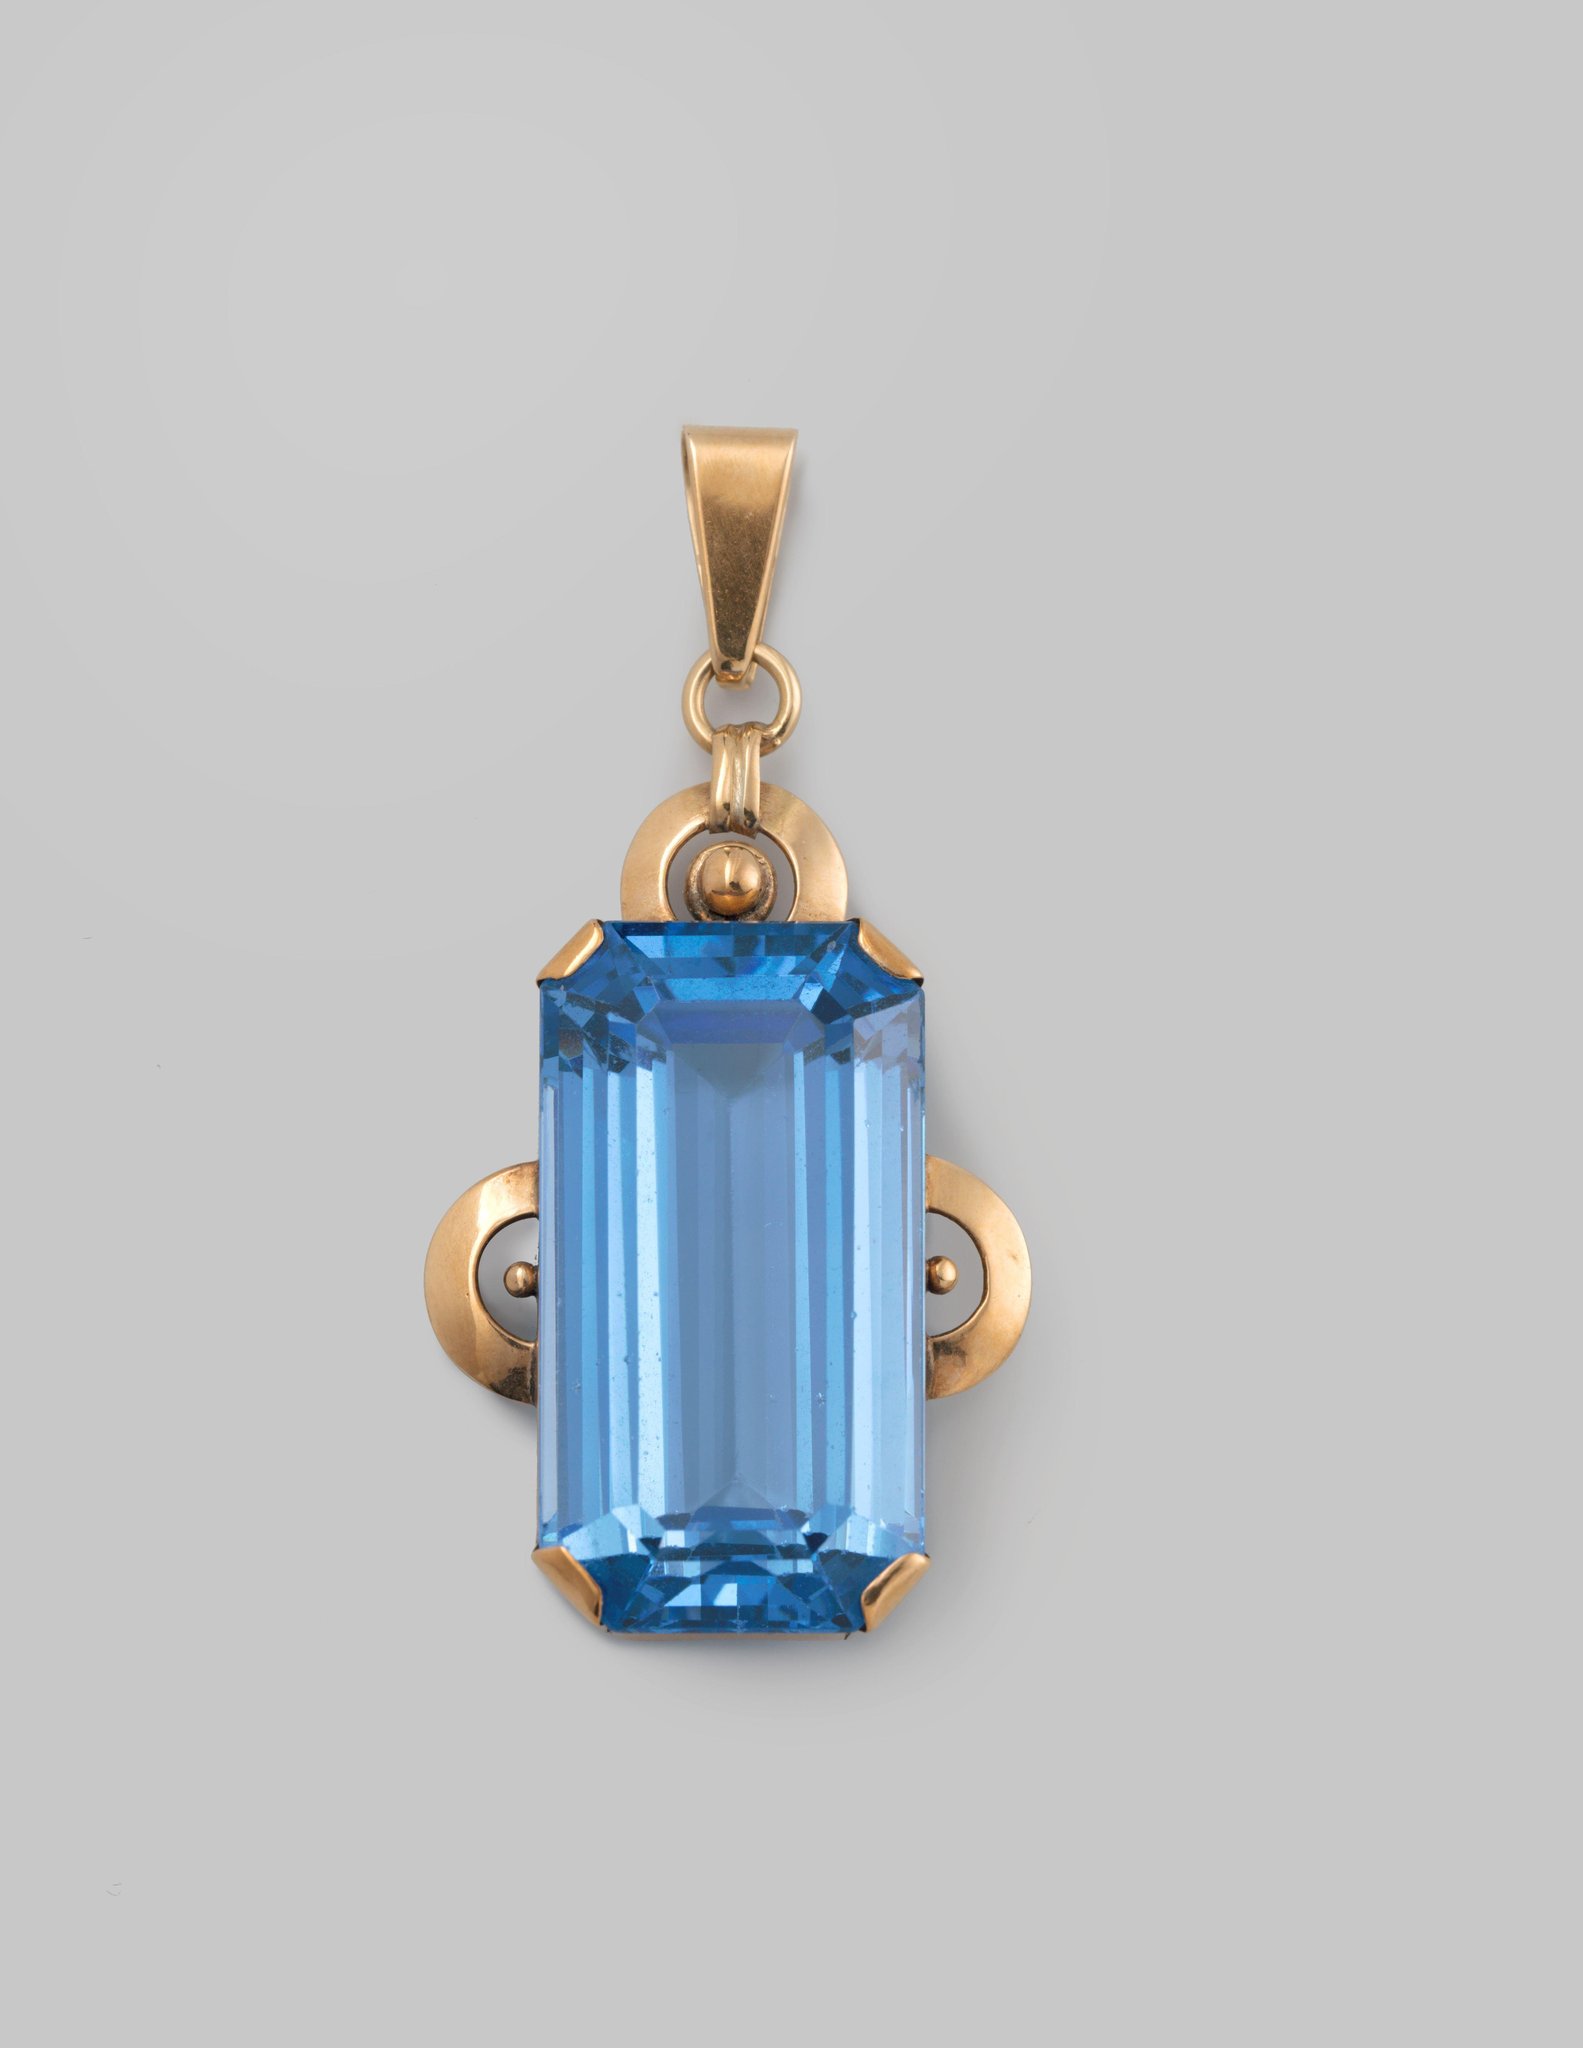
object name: pendant jewelry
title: Hanger van goud met synthetisch blauw gekleurde spinel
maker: e. lodema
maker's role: jeweler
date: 1930-1950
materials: gold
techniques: faceting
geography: amsterdam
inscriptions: maker's mark: ‘EL4’, alloy mark: ‘(oud) eikenblad’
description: Hanger van goud met synthetisch blauw gekleurde emeraude gefacetteerde spinel voorzien van een plaatoog. De rechthoekige spinel is staand gevat en heeft in het midden van zowel weerszijden als de bovenzijde een halve cirkel van goud met daarin een bol.